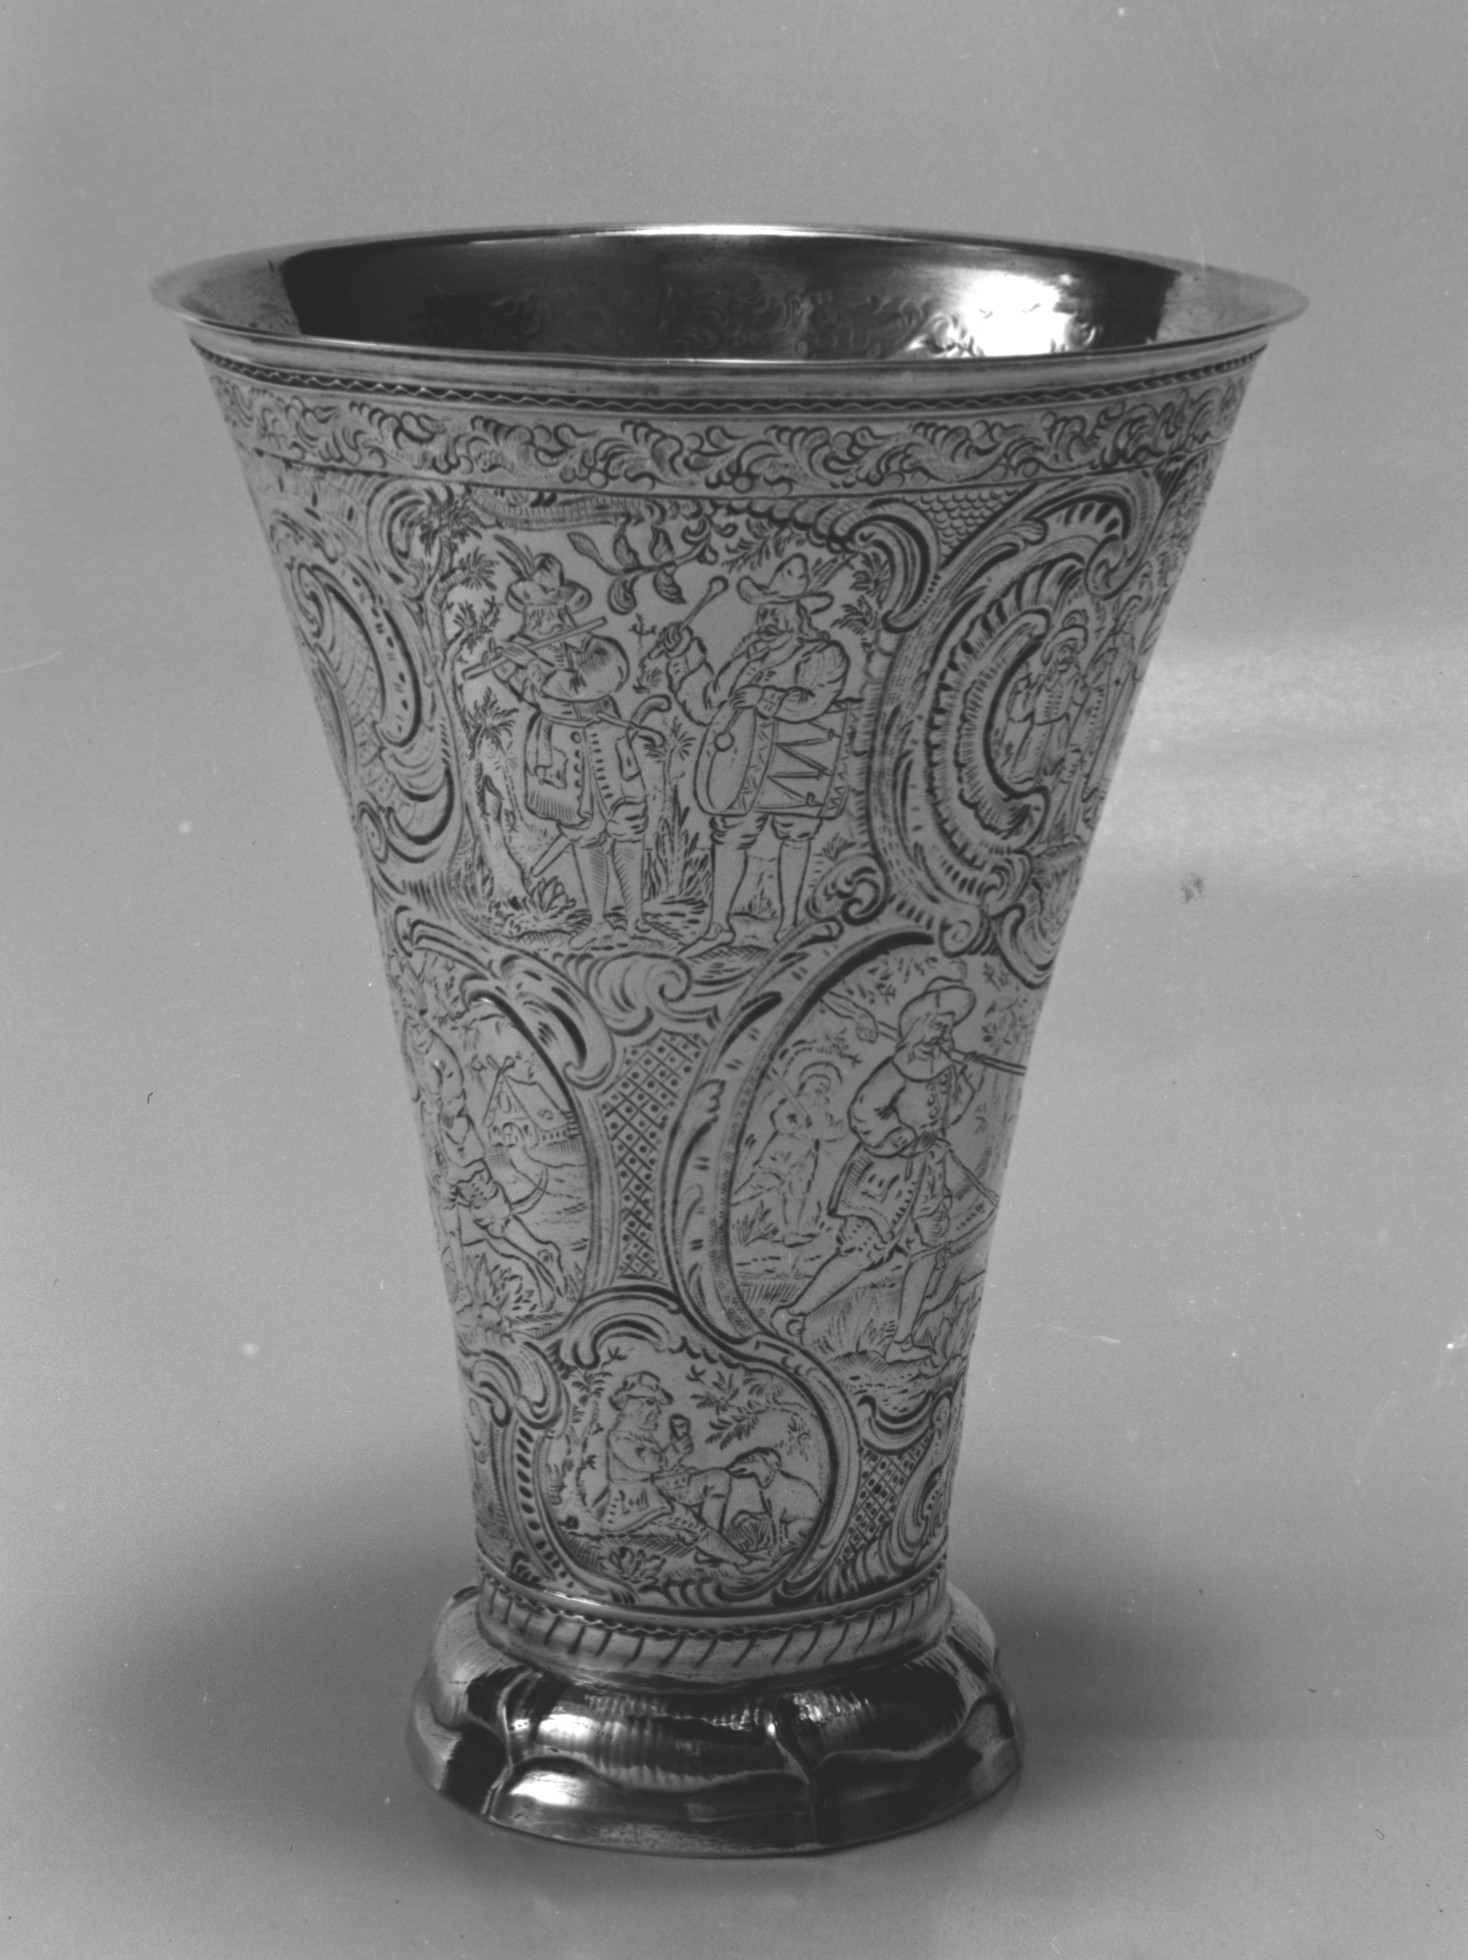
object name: beaker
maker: matthias forswall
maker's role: maker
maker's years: 1773-1786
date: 1776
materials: gilt, silver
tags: musical instruments,men,dogs,musicians